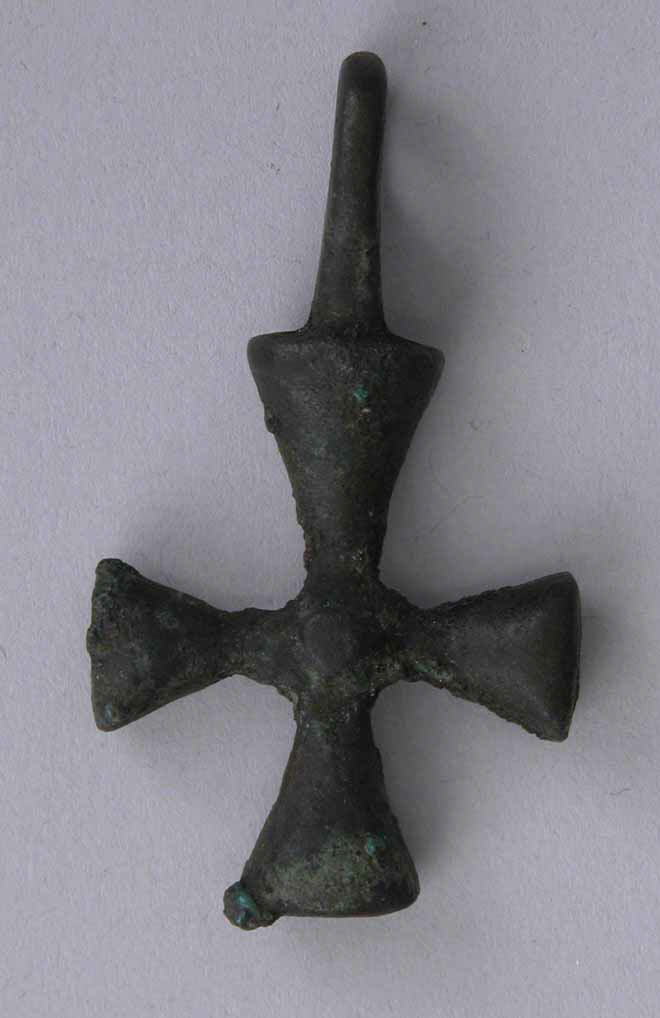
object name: cross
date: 201-1200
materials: bronze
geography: egypt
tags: cross